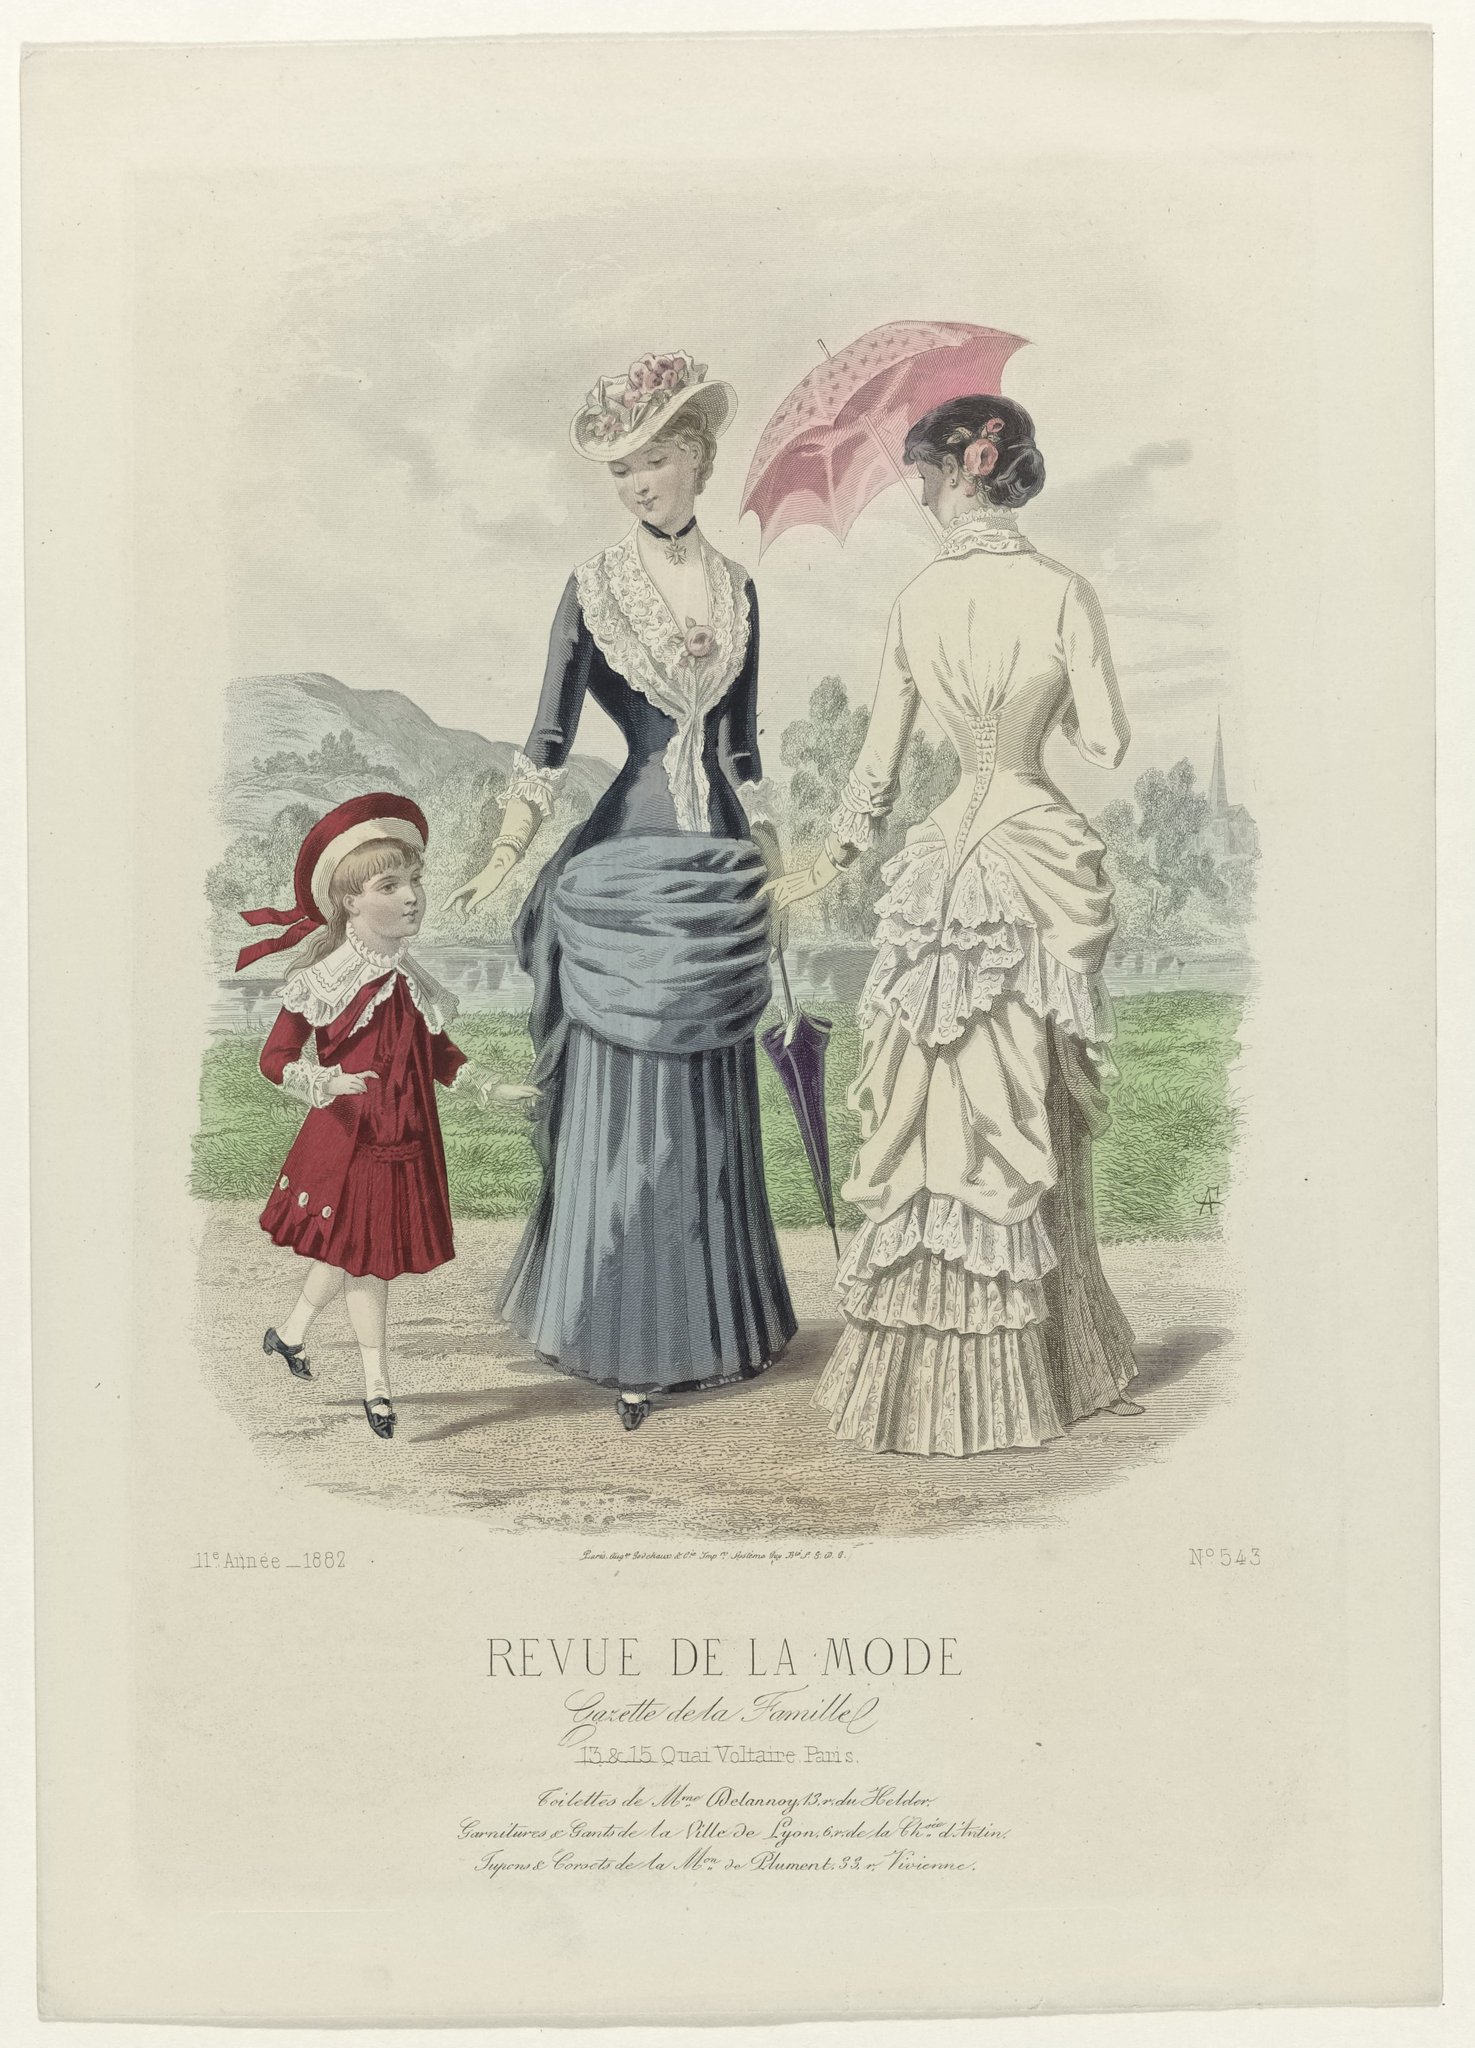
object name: fashion print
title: Revue de la Mode, Gazette de la Famille, dimanche 28 mai 1882, 11e année, No. 543: Toilettes de Mme Delannoy (...)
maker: Anonymous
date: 1882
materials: paper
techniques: engraving, hand coloring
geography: paris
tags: pendant, trinket, 'breloque' (+ women's clothes), gloves, mittens (long gloves) (+ women's clothes), clothing for the upper part of the body (shawl) (+ women's clothes), lace (+ women's clothes), neck-gear: collar (+ girls' clothes), fashion plates, head-gear: hat (+ women's clothes), dress, gown (+ women's clothes), parasol, sunshade (+ women's clothes), dress, gown (+ girls' clothes)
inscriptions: caption: ‘Toilettes de M.me Delannoy, 13, r. du Helder. Garnitures & Gants de la Ville de Lyon, 6, r. de la Ch.sée d'Antin. Jupons & Corsets de la M.on de Plument, 33, r. Vivienne.’, address: ‘13 & 15, Quai Voltaire, Paris’, title: ‘REVUE DE LA MODE / Gazette de la Famille’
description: Twee vrouwen en een meisje wandelend langs een rivier, gekleed in japonnen van Delannoy. Het kind draagt een japon van rode 'surah' en/of wol en een matrozenhoed van stro afgezet met velours. Links: 'toilette de château' van grijs satijn, voile en velours. Rechts: 'toilette de château' van 'foulard pompadour', crèmekleurige kasjmier en gegarneerd met kant. Onder de afbeelding enkele regels reclametekst voor verschillende producten. Prent uit het modetijdschrift Revue de la Mode (1872-1913). Uitgebreide beschrijving van de kleding op pagina 181 "PLANCHE COLORIÉE".